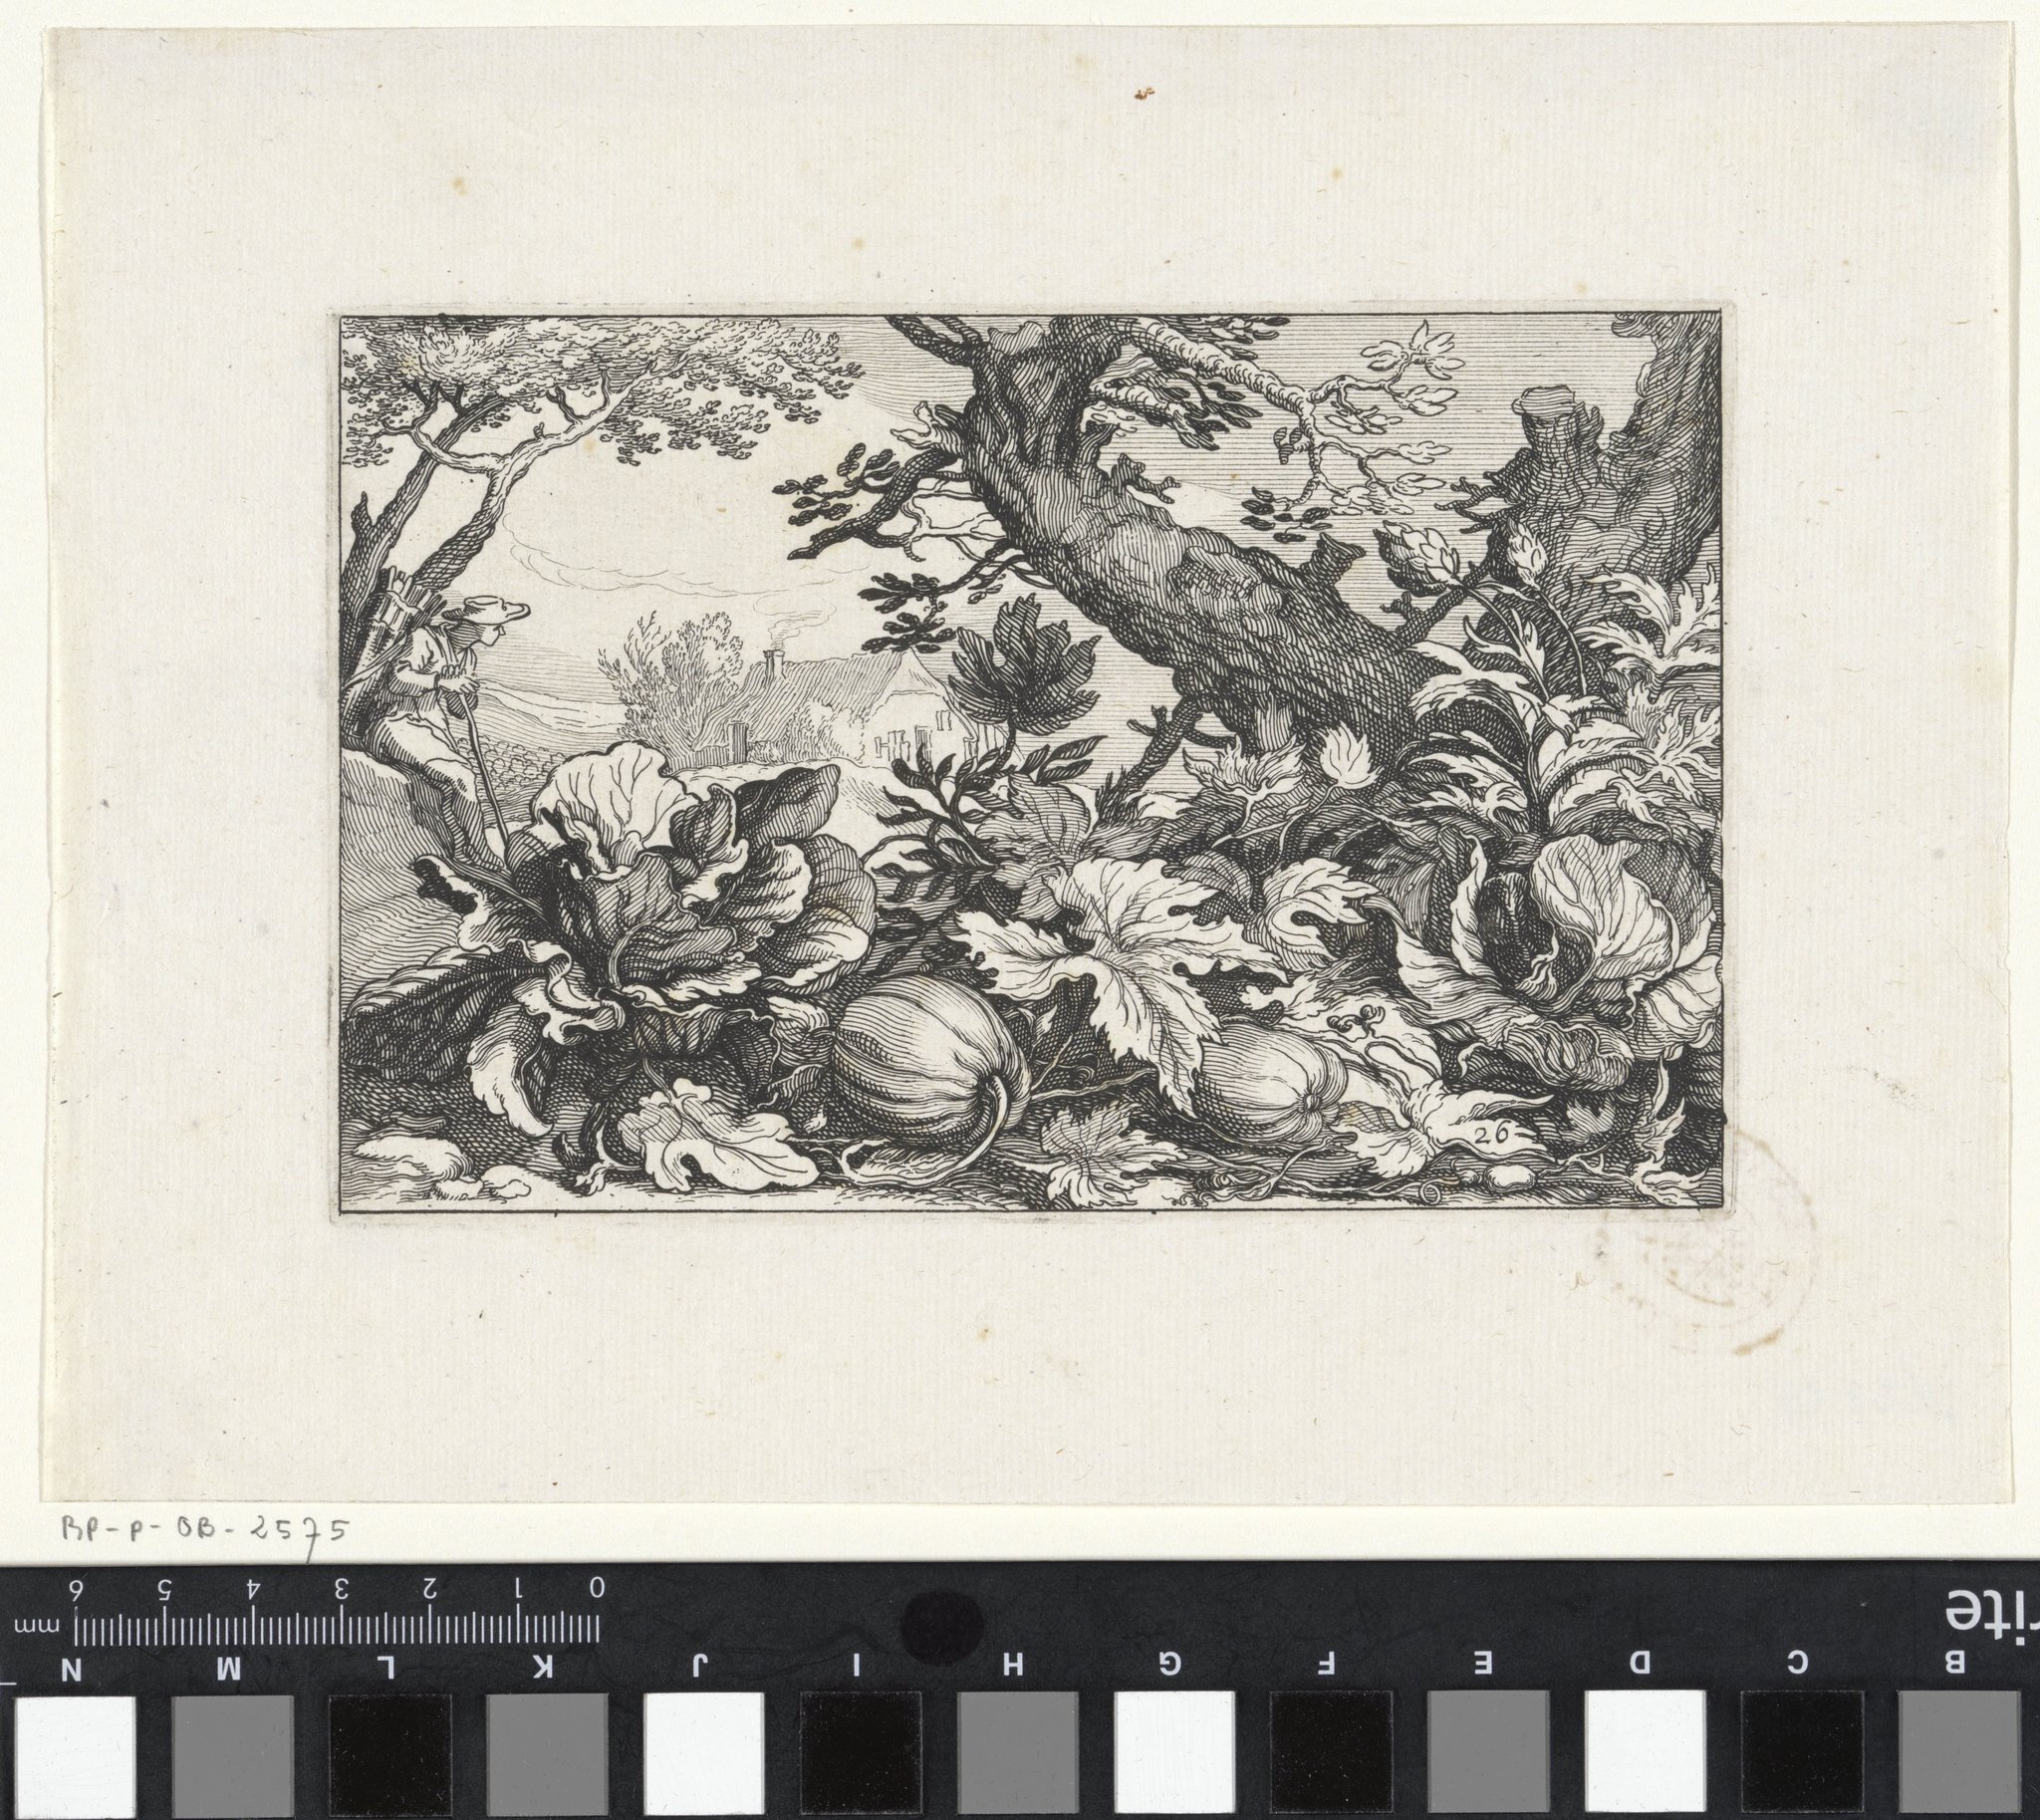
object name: print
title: Landschap met pompoenen en kolen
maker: claes jansz. visscher (ii)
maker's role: draughtsman, print maker, publisher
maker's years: 1586-1652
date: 1620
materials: paper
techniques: etching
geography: amsterdam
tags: landscapes, farm or solitary house in landscape, fruits: pumpkin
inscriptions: collector's mark: Lugt 240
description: Landschap met pompoenen en kolen op de voorgrond en links een herder. Op de achtergrond een boerderij met een rokende schoorsteen.